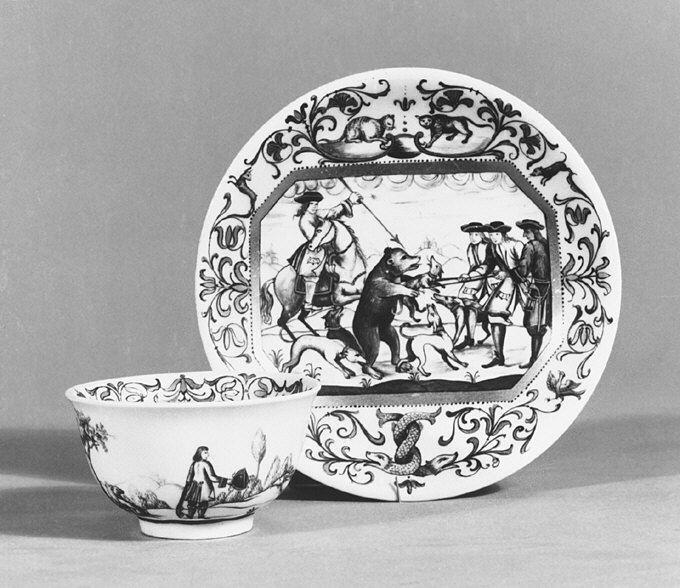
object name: cup and saucer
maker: meissen manufactory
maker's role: manufactory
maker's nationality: german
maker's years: 1710-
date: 1730-1740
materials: hard paste porcelain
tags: hunting,dogs,horses